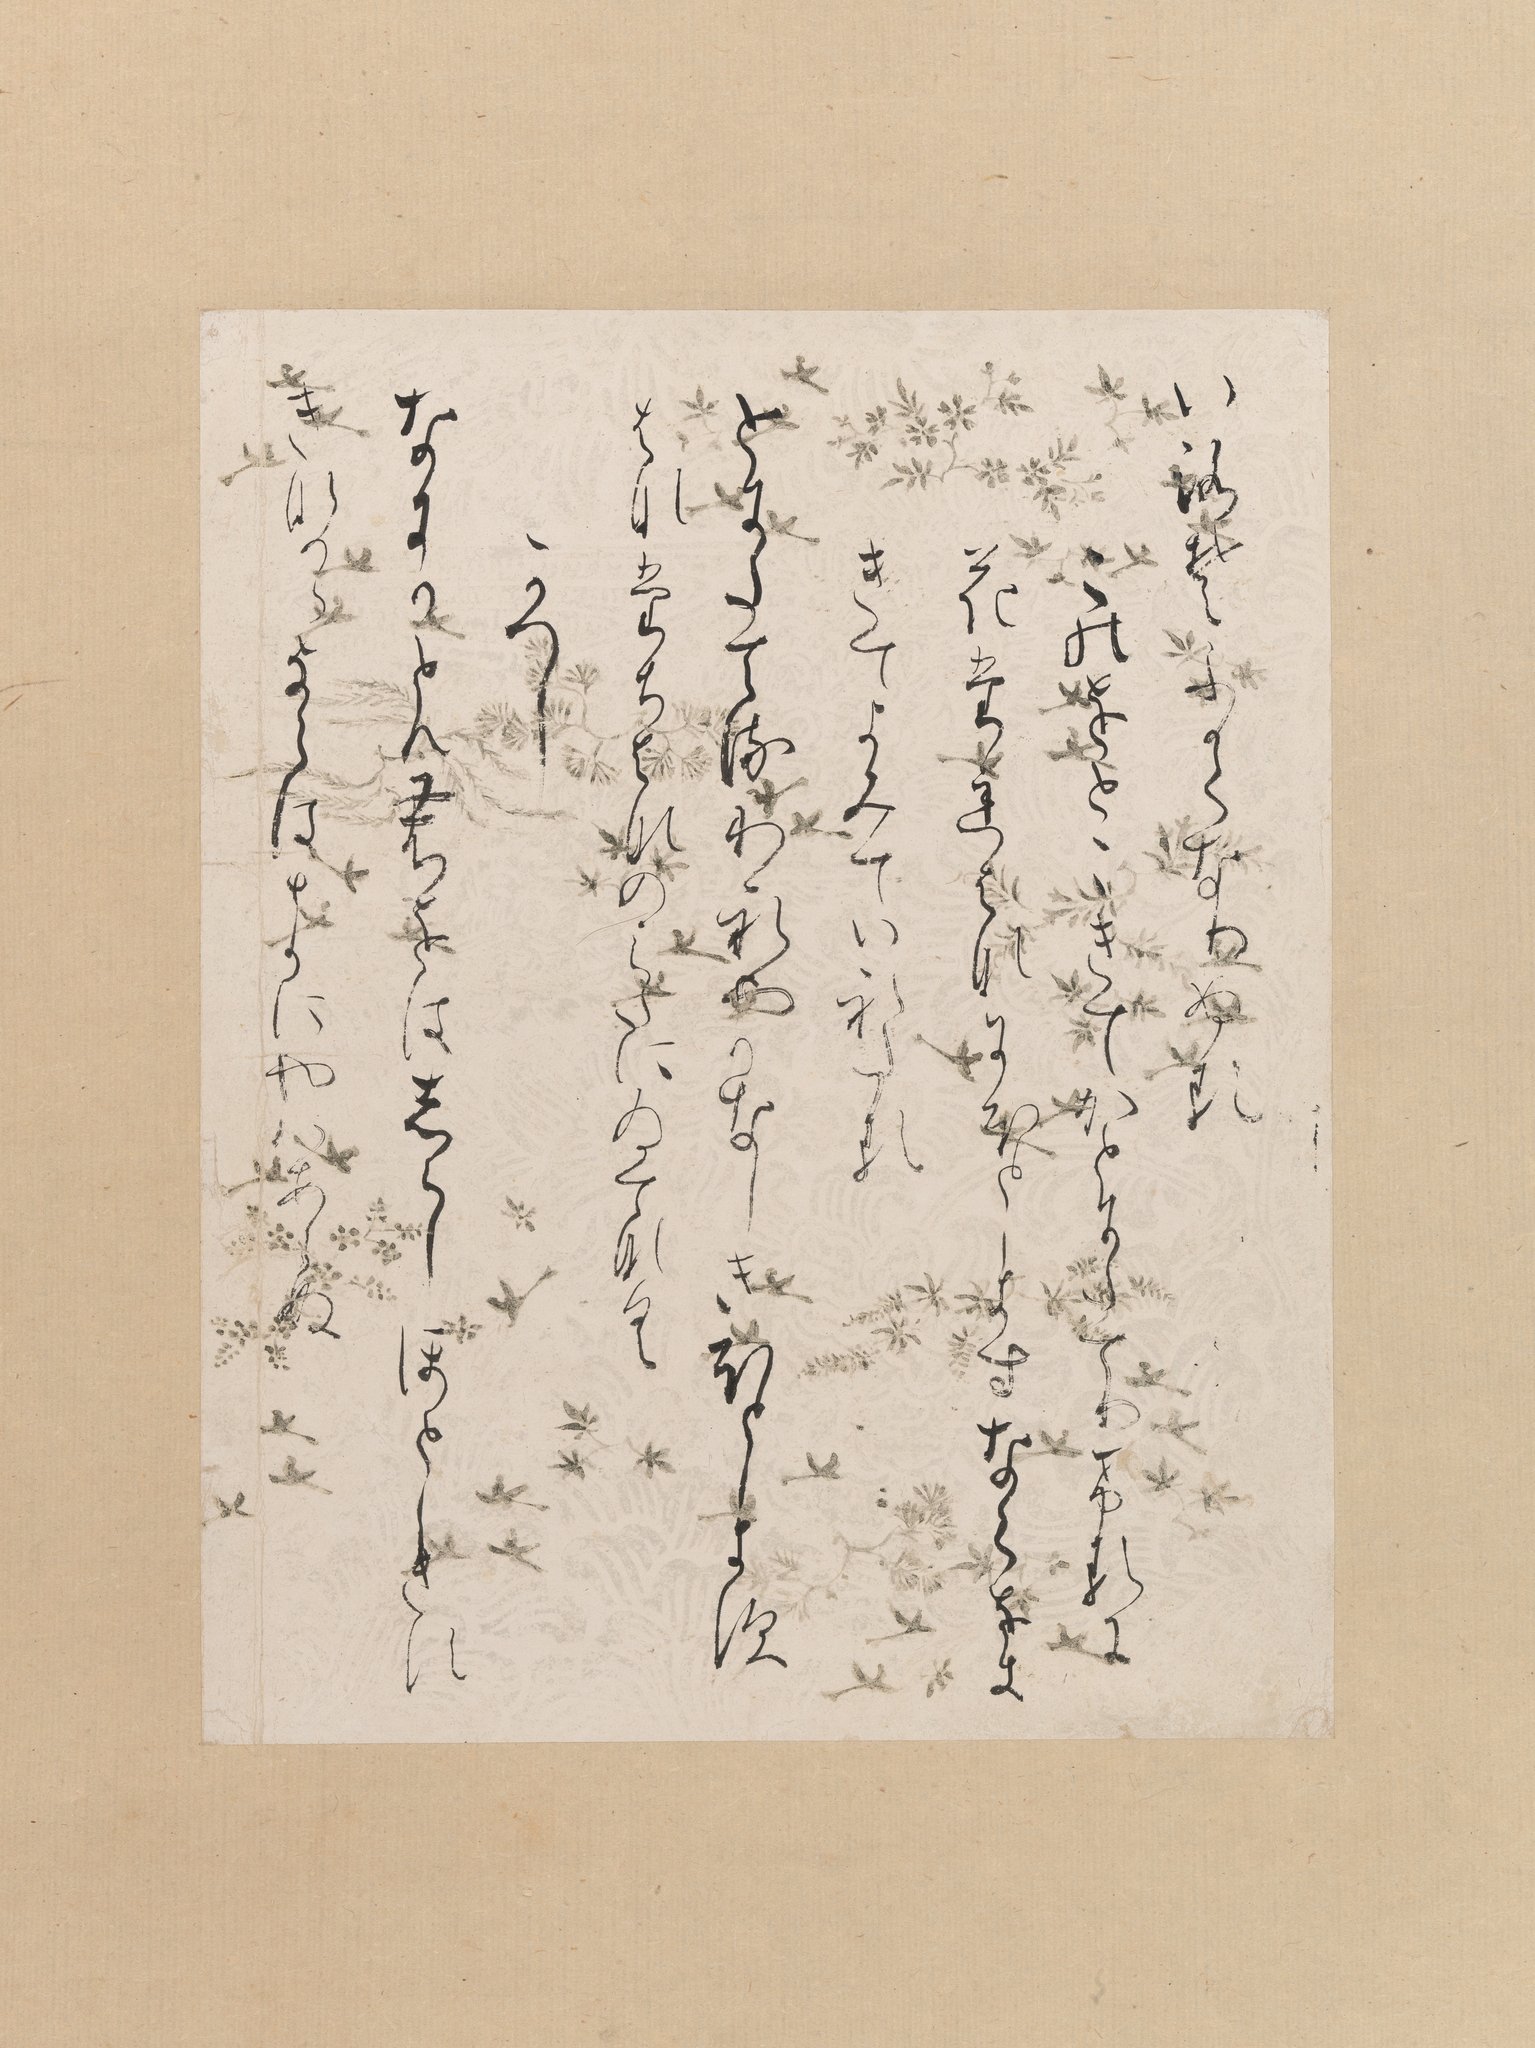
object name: hanging scroll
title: Page from the Collection of Poems by Lady Ise (Ise shū)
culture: japanese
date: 1101-1133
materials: ink, paper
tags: poetry